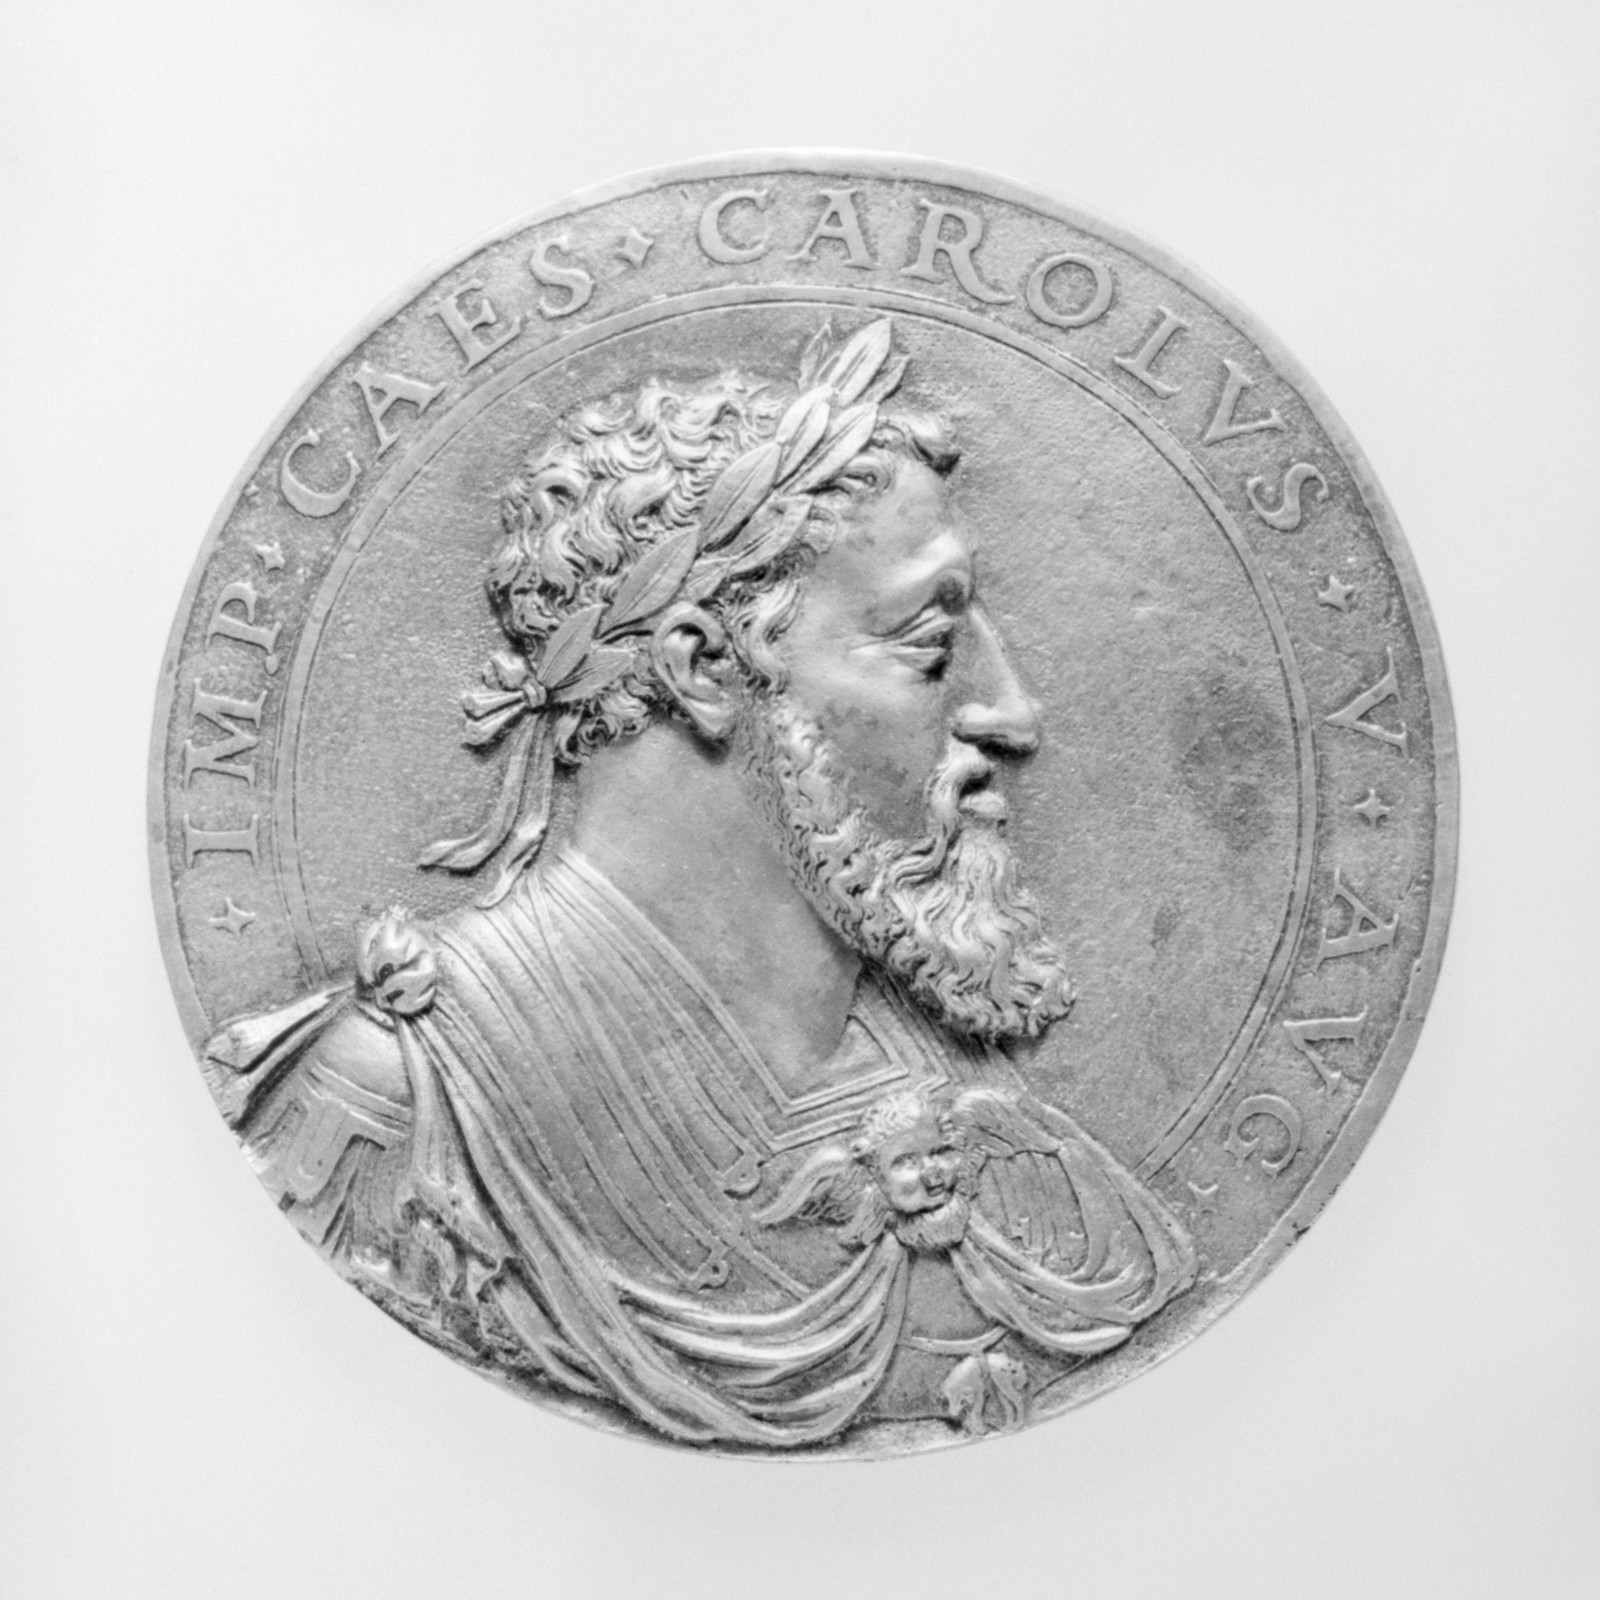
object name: medal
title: Charles V (1500–1558), Emperor of the Holy Roman Empire (1519–56)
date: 1501-1600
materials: gilt bronze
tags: men,profiles,horses